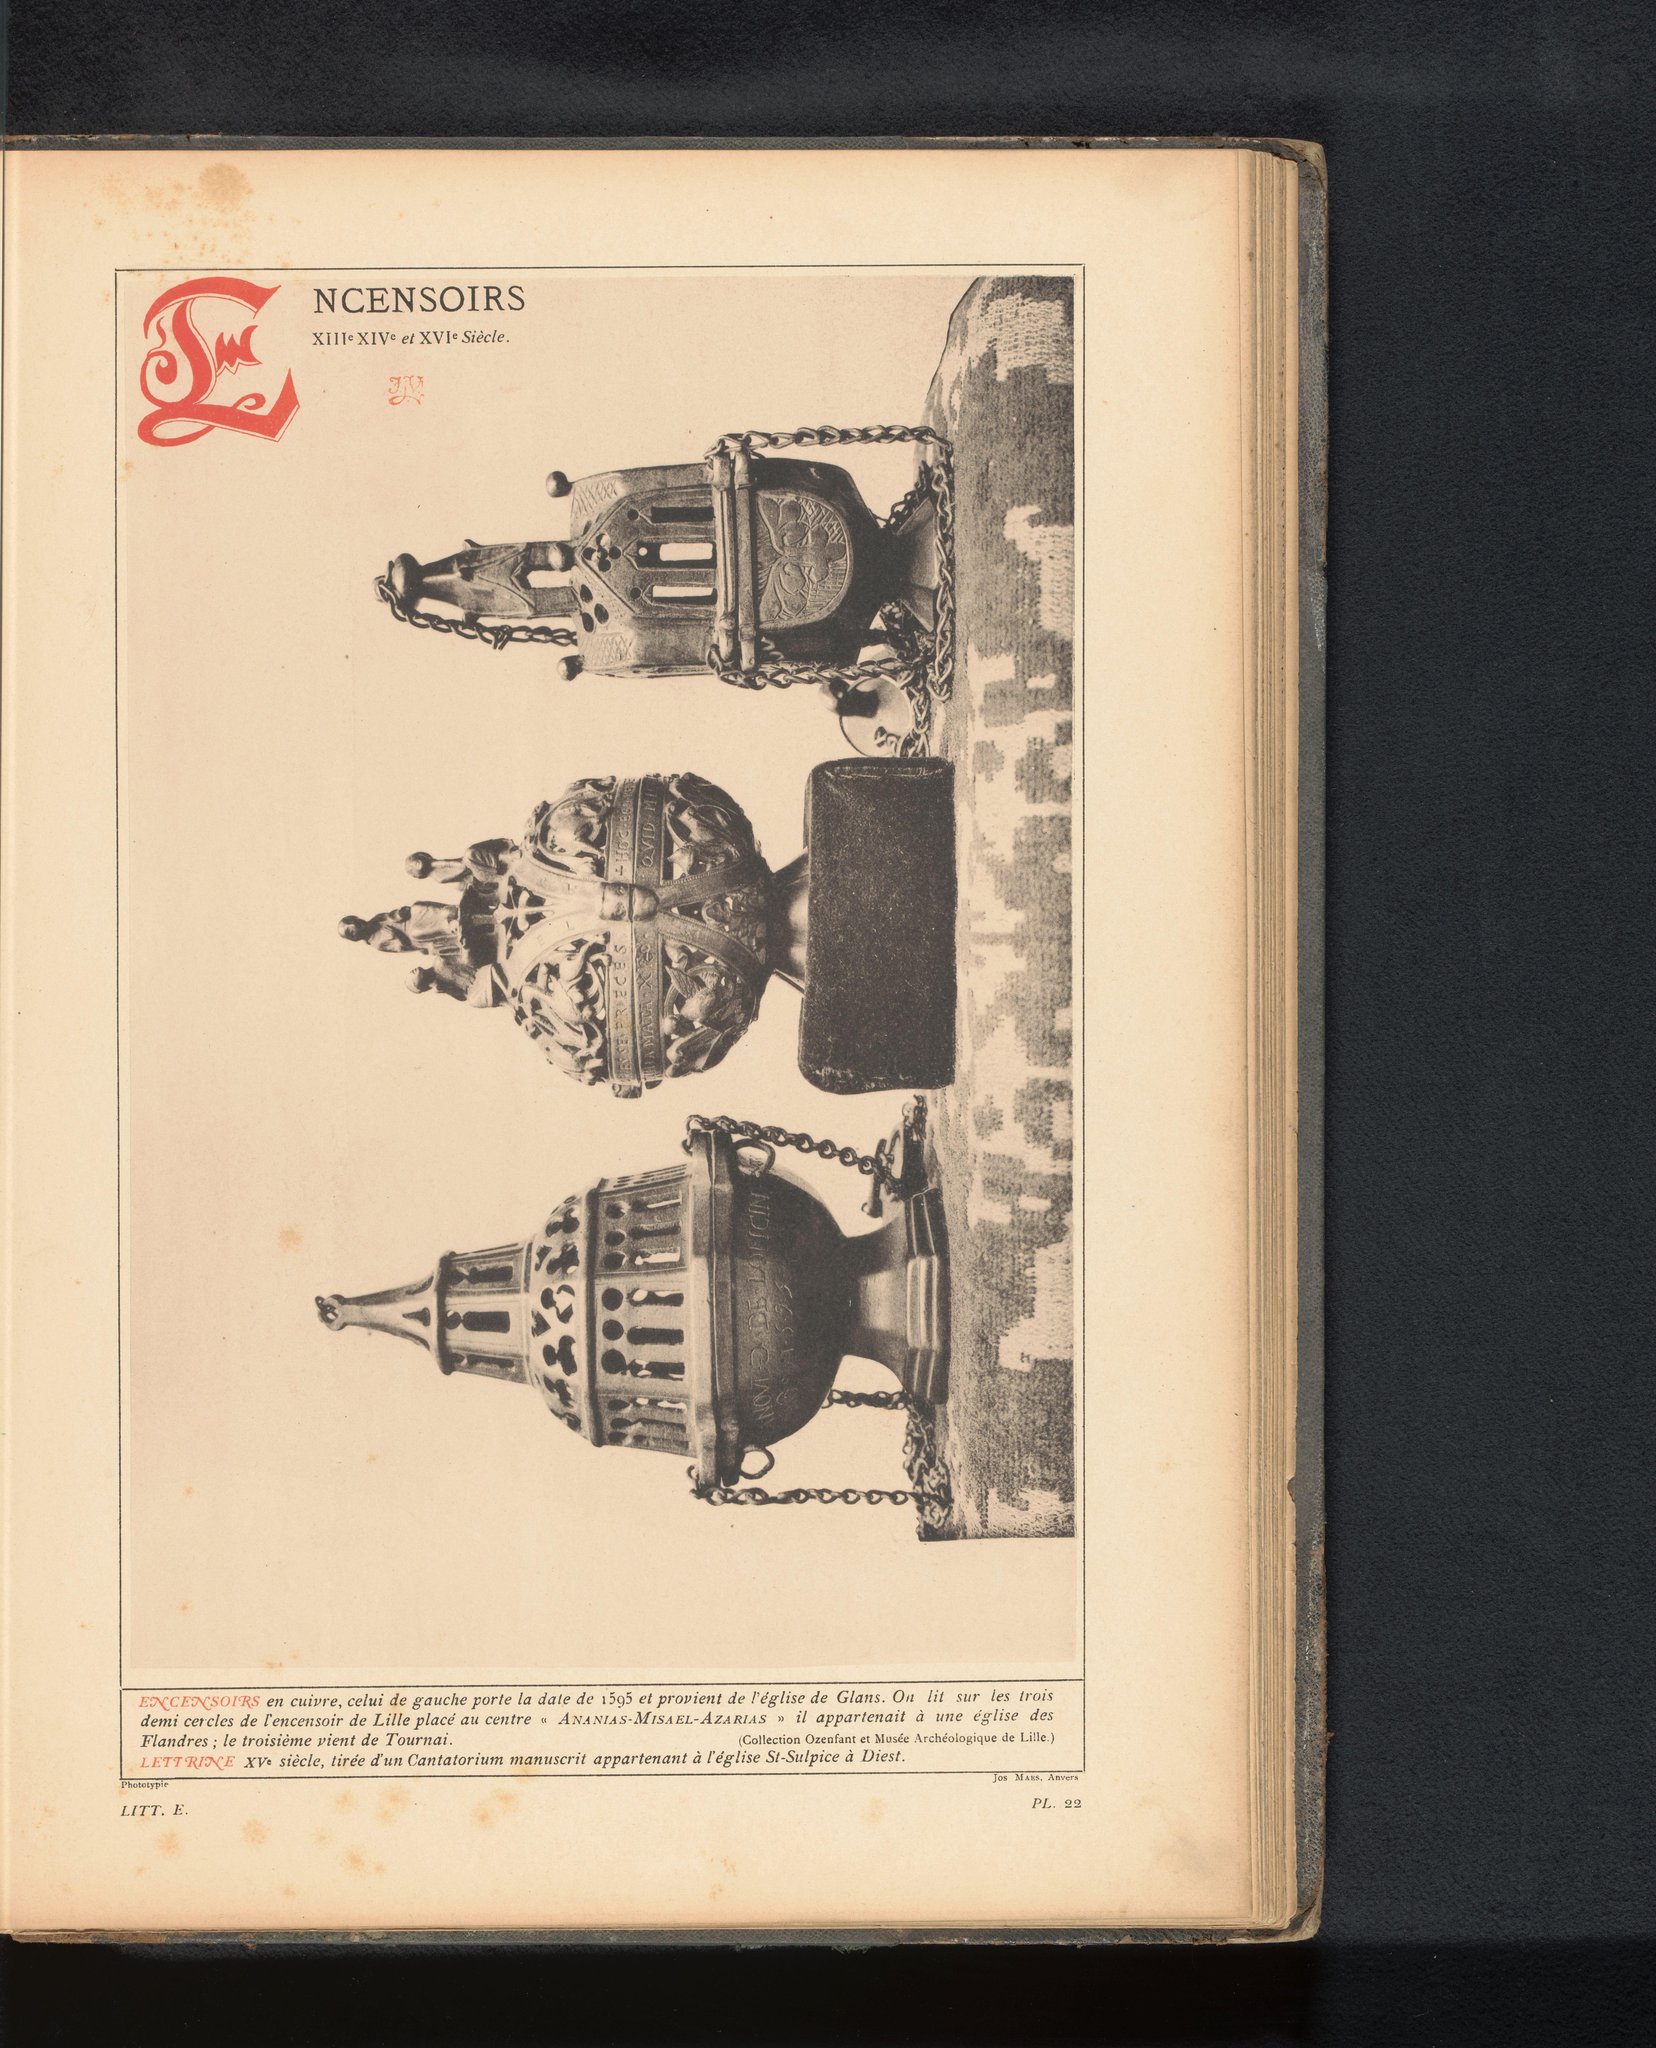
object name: photomechanical print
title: Encensoirs, XIIIe, XIVe et XVIe Siècle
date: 1875-1880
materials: paper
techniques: photograph, photolithography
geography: diest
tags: censer, belgium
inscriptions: monogram: ‘JJvY’, inscription: ‘ENCENSOIRS en cuivre (...)’, inscription: ‘LITT. E. - PL. 22’